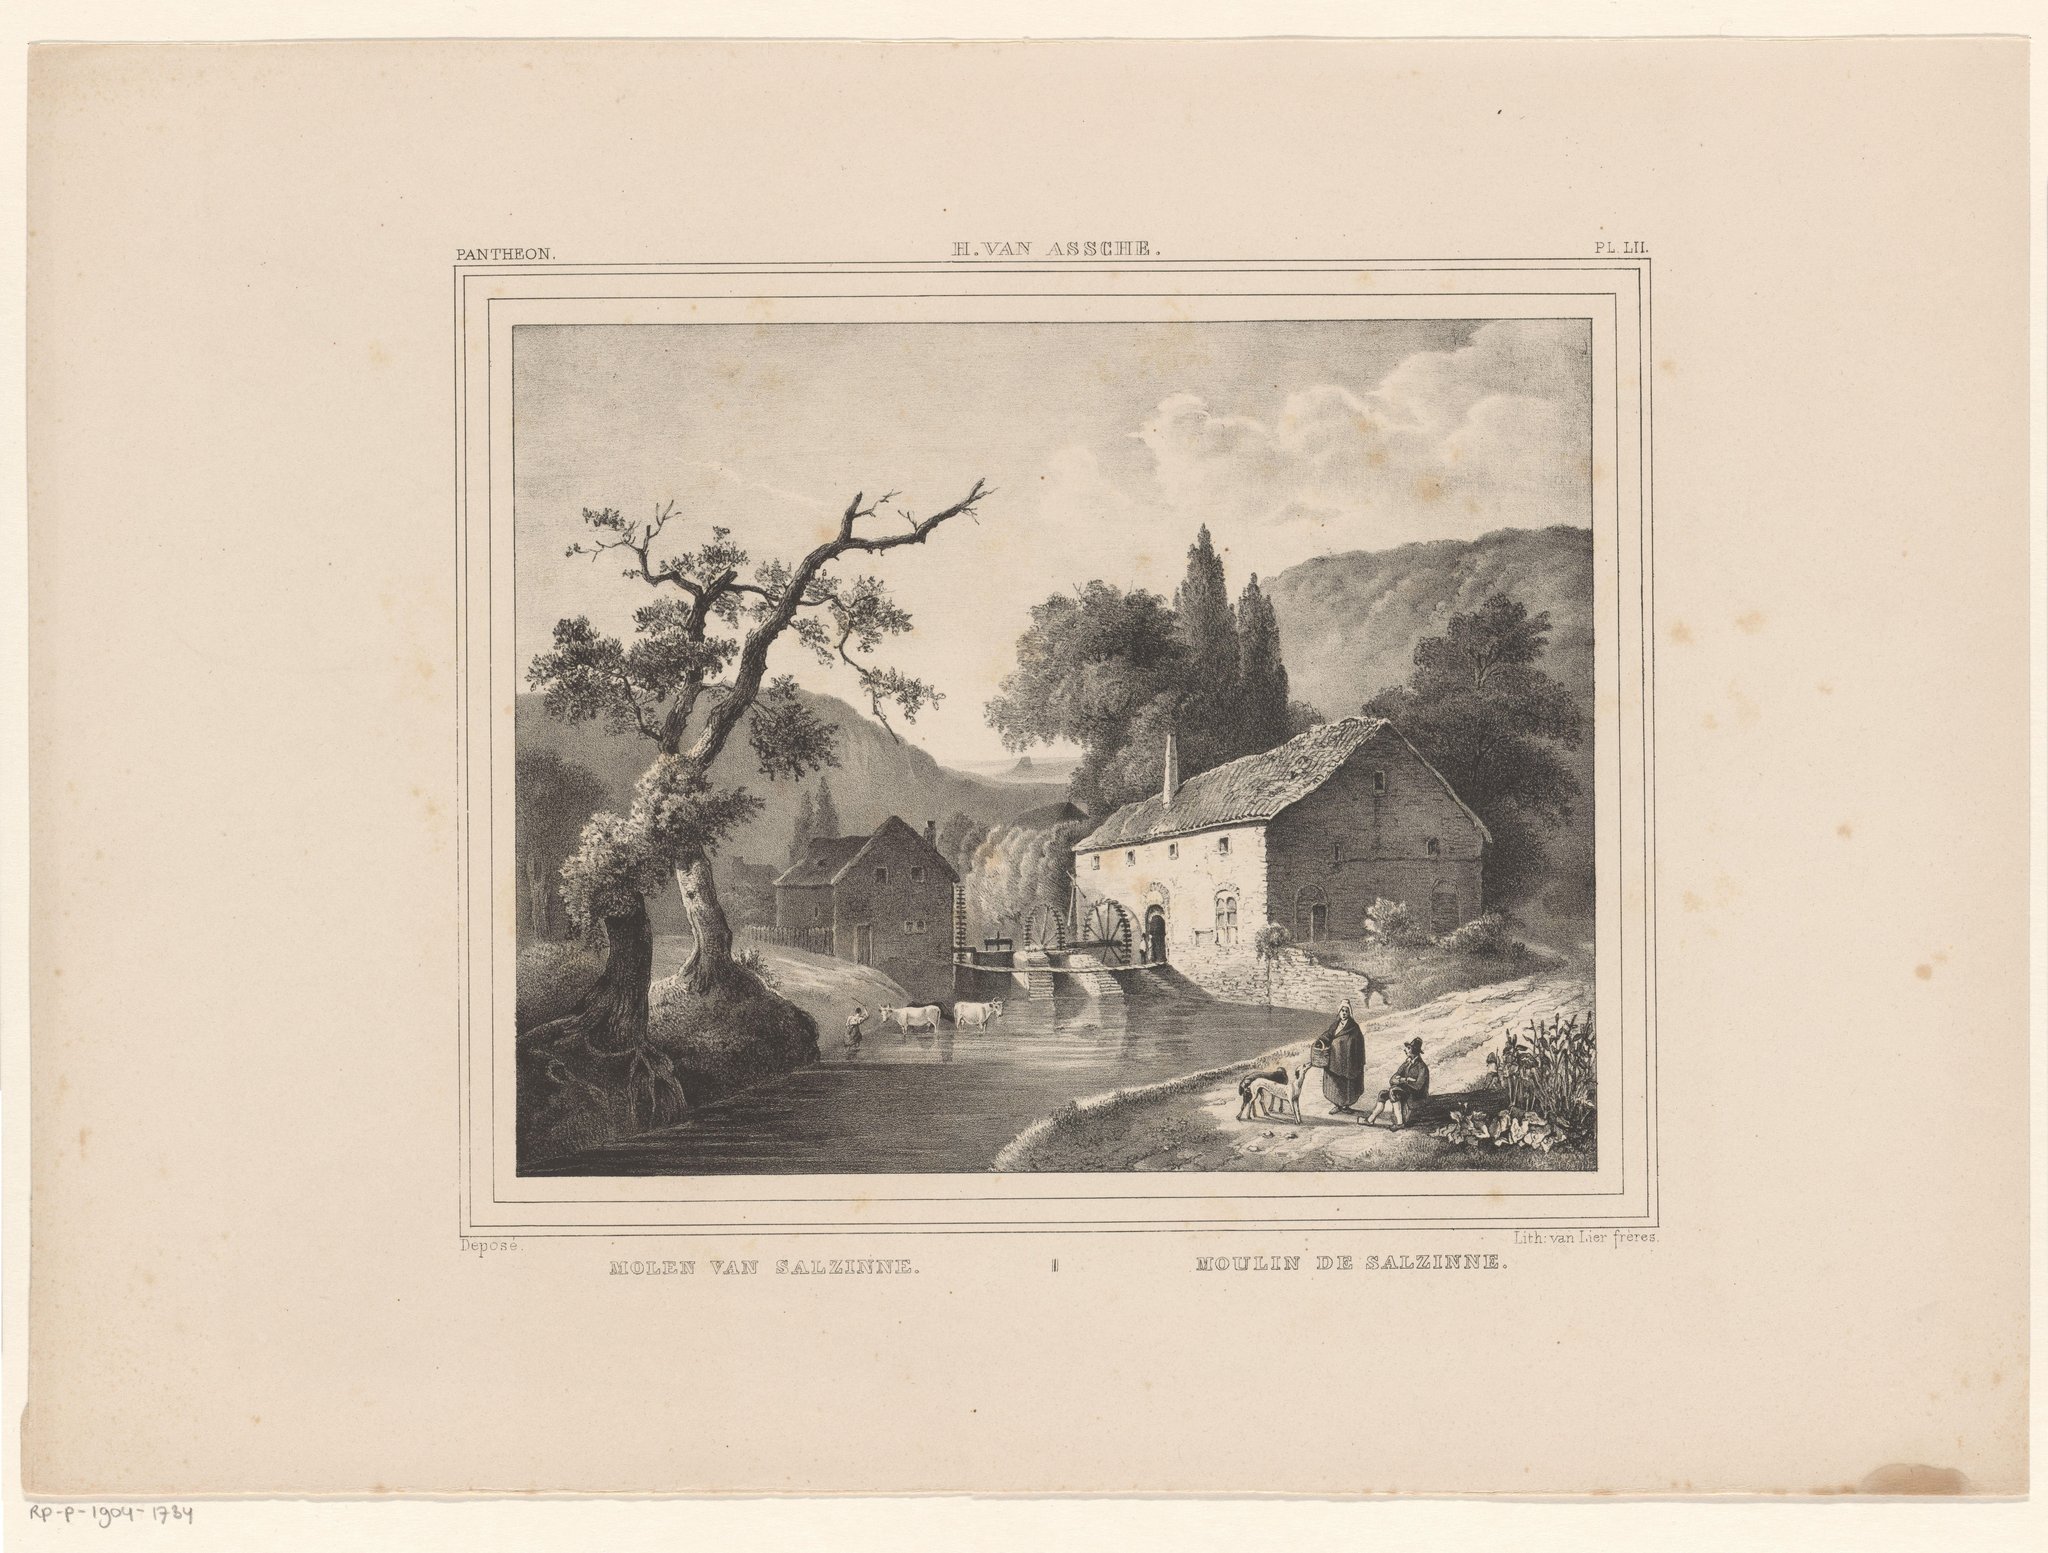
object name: print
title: Molen van Salzinne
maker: henri van assche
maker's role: print maker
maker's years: 1774-1841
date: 1837-1843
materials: paper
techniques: lithograph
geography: the hague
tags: watermill in landscape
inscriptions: collector's mark: Lugt 2228, : ‘Deposé’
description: Deze prent maakte mogelijk deel uit van: Pantheon of de tempel der onsterfelijkheid van Nederlandse kunstschilders. Uitgegeven door Gebroeders Van Lier in Amsterdam tussen 1837 en (in ieder geval) 1843.